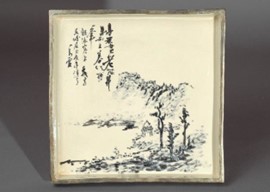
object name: dish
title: Square Dish with Landscape and Poem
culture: japanese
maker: kiyomizu rokubei v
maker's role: artist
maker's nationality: japanese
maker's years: 1875-1959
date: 1929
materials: cobalt, gold, porcelain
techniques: overglaze, underglaze